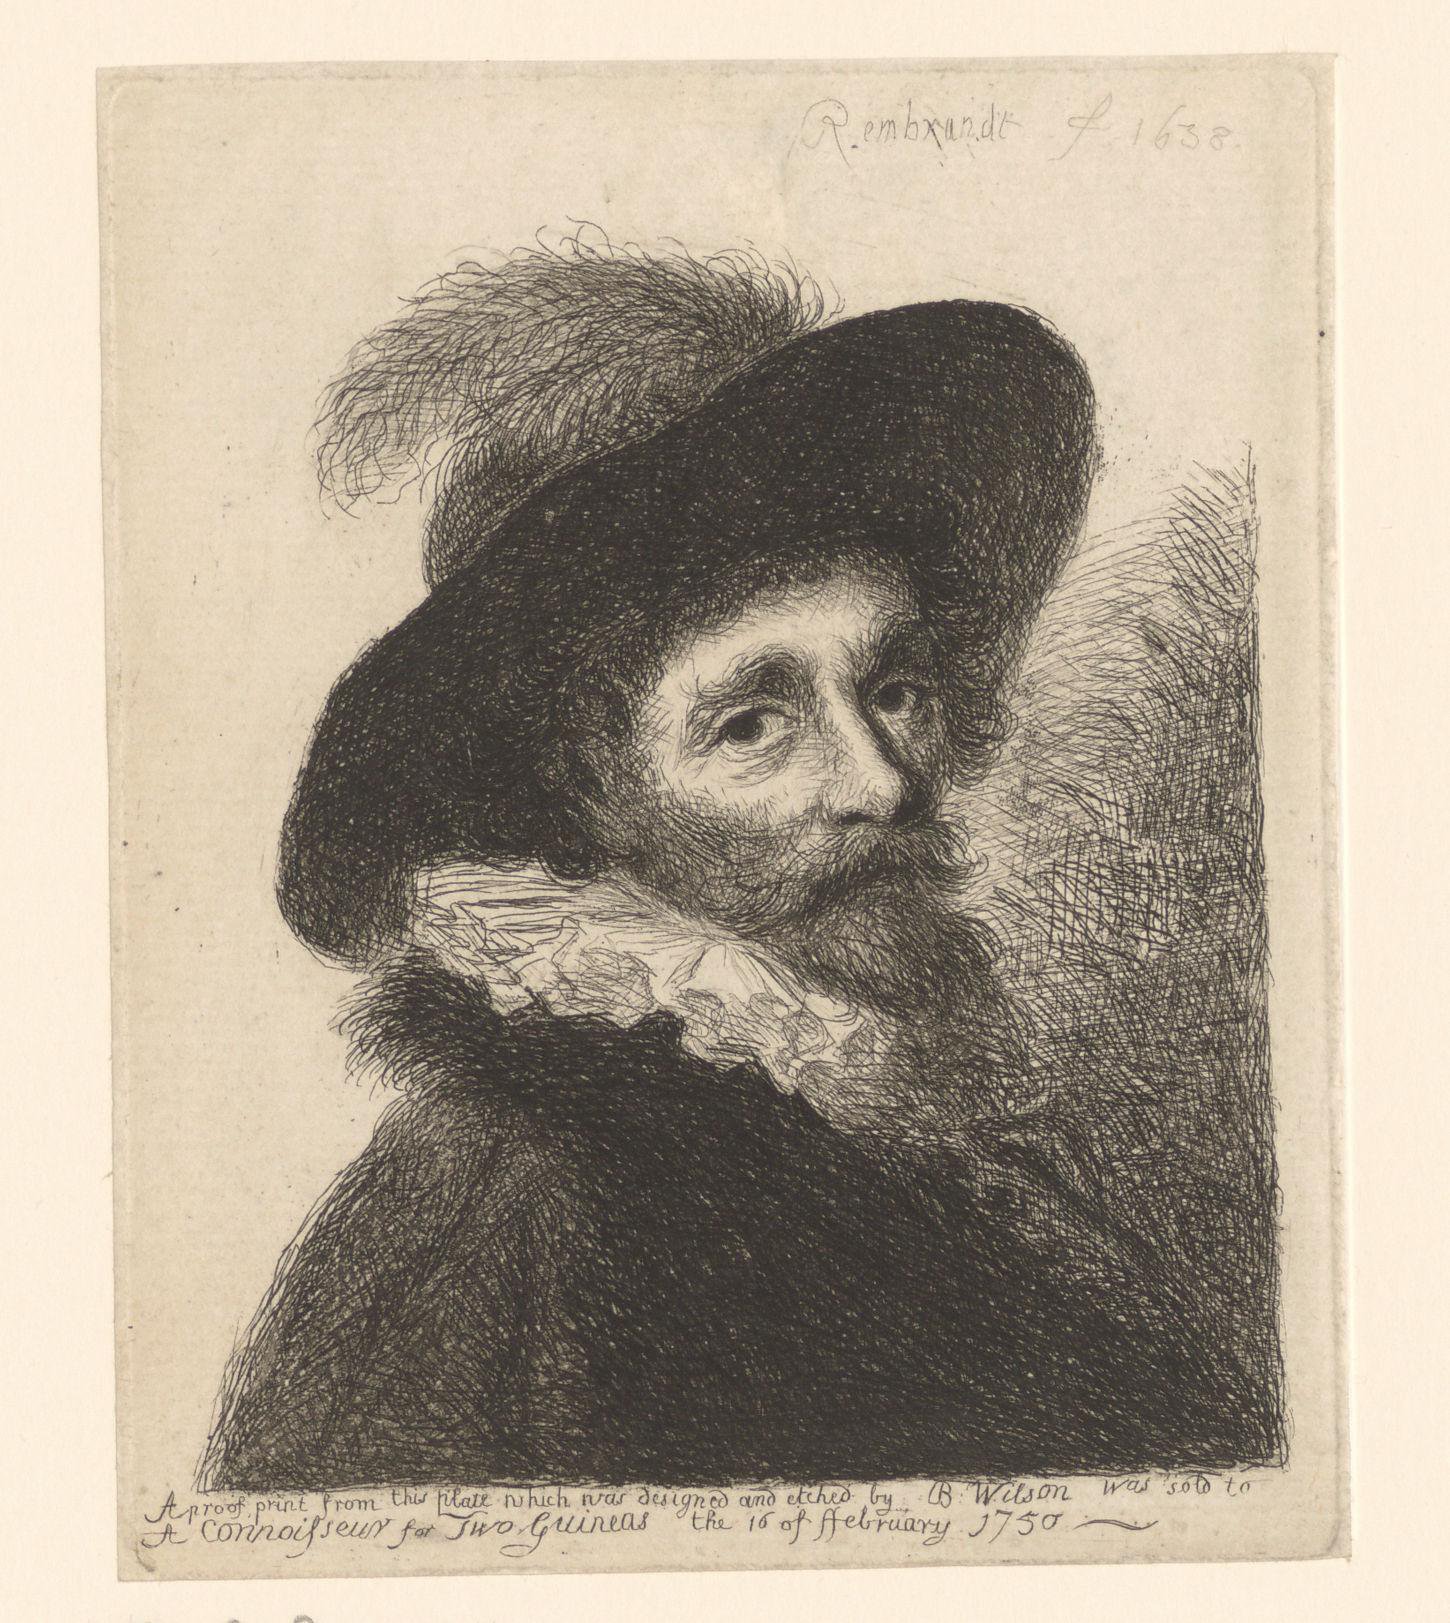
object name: print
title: Portret van man met hoed met veer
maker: benjamin wilson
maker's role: painter, print maker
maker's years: 1721-1788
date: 1750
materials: paper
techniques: etching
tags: head-gear: hat, historical persons not known by name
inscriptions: collector's mark: Lugt 2228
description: Dit was een van de prenten die Benjamin Wilson in een eerdere staat liet verkopen aan Rembrandt-connaisseurs als een echte Rembrandt.